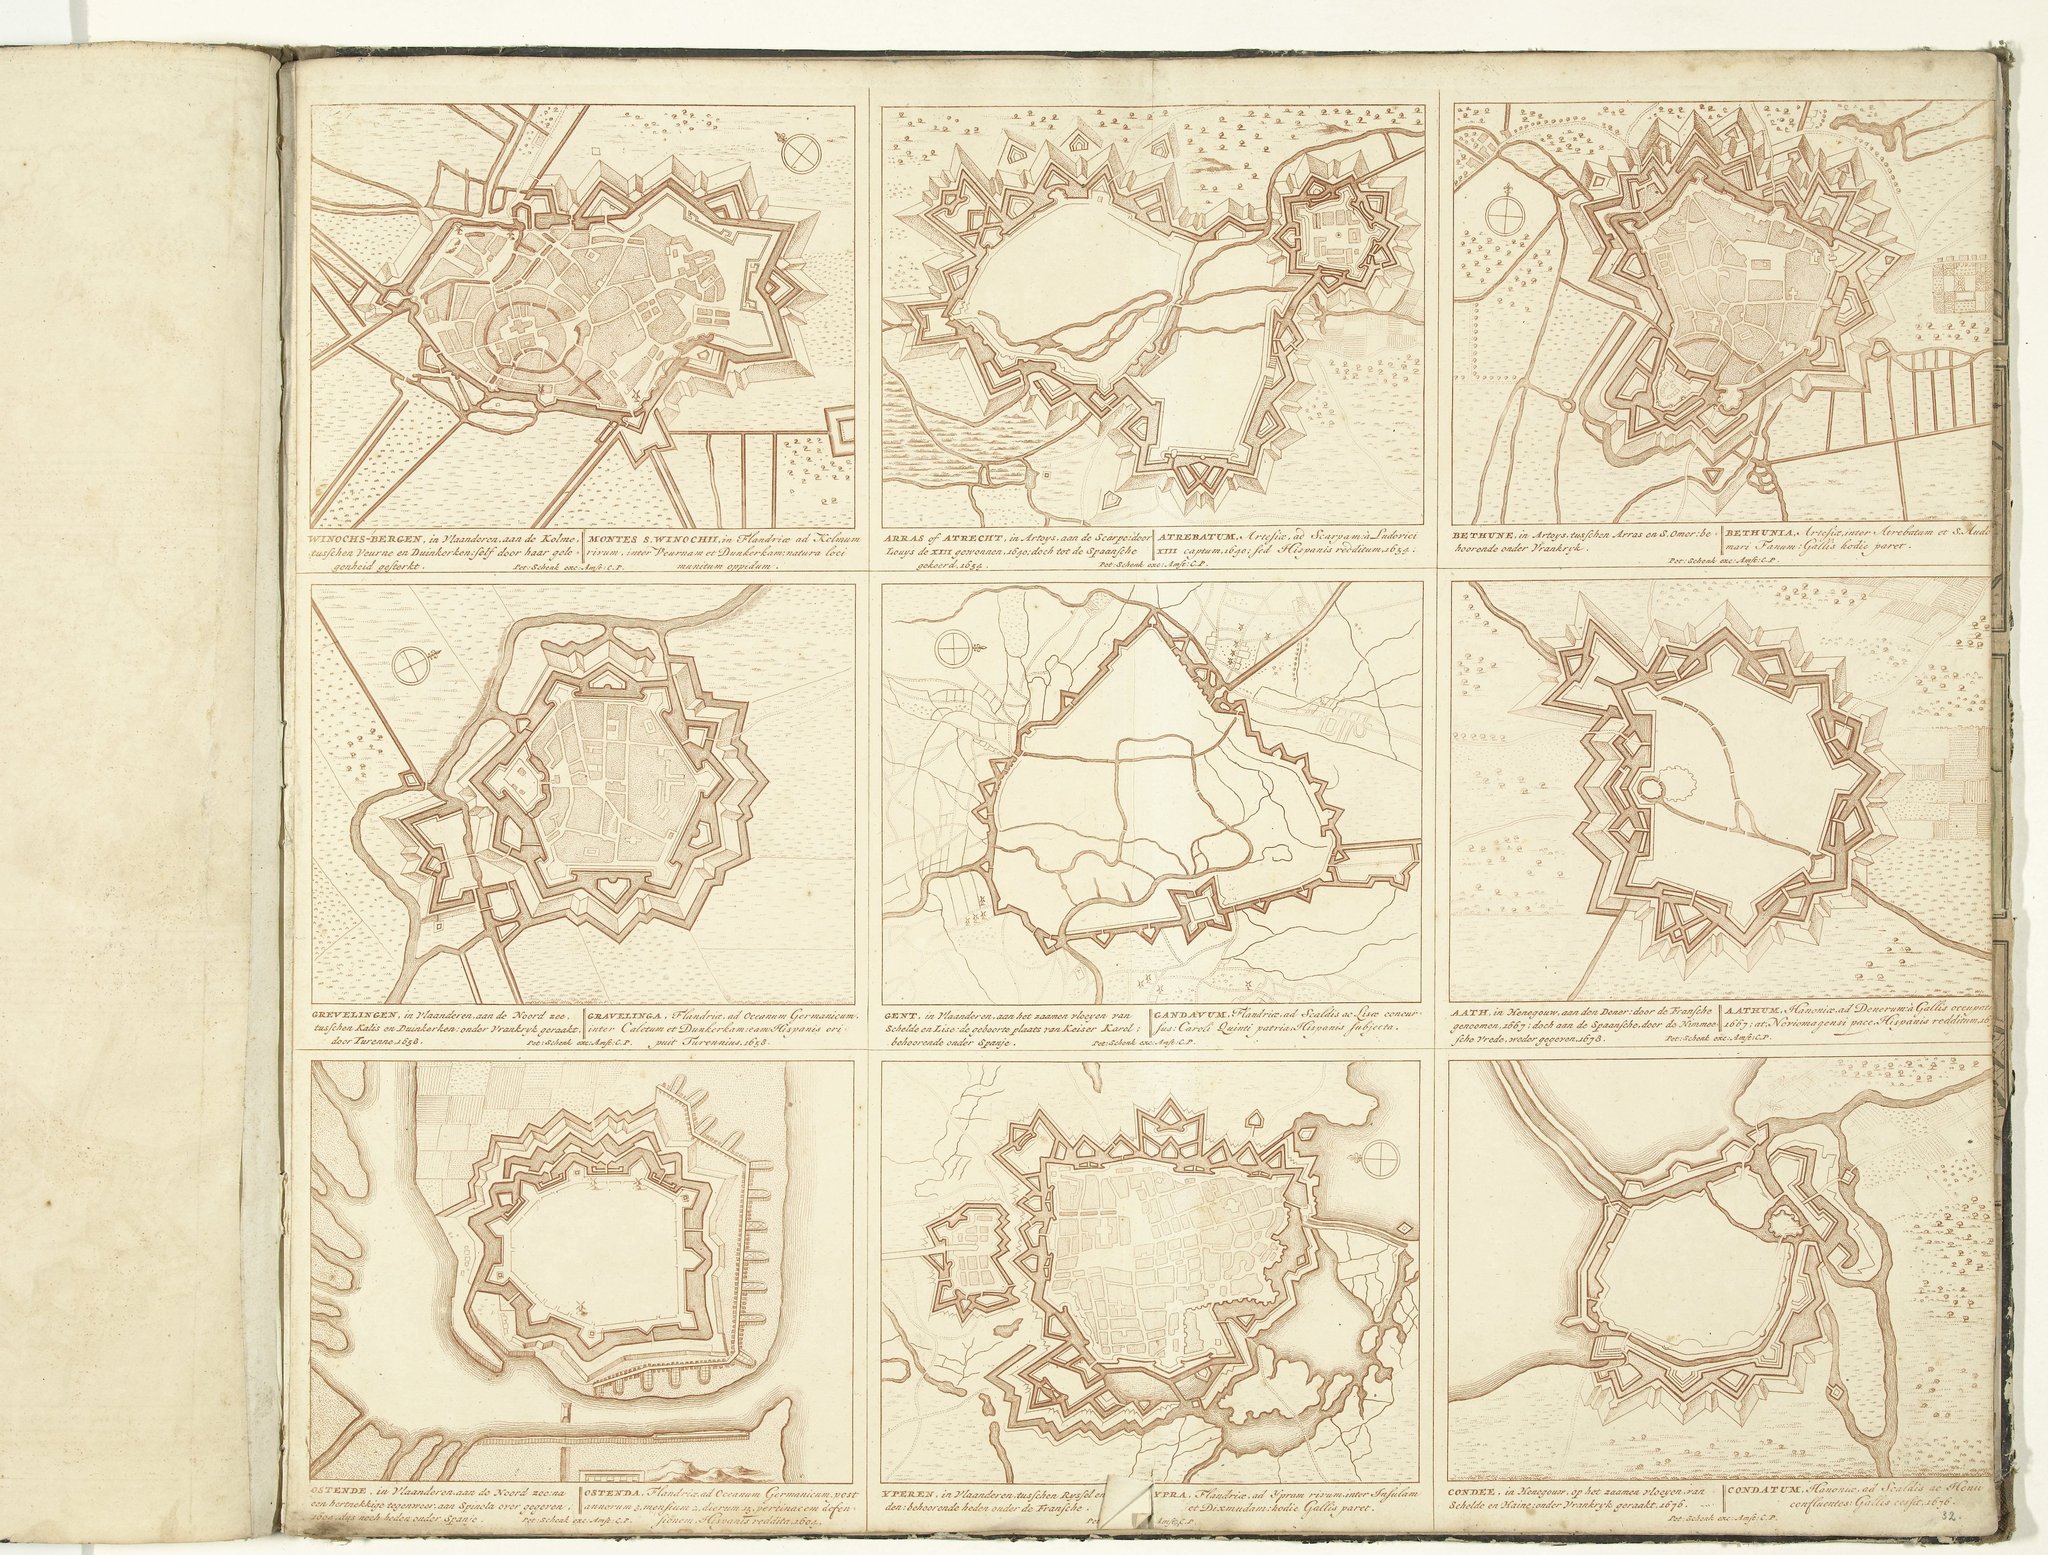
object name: print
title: Schouwburg van den oorlog (blad XXXII), ca. 1700-1710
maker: pieter schenk (i)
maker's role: print maker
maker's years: 1660-1711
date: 1700-1710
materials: paper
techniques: etching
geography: amsterdam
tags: fortress, maps of cities, ghent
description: Blad met negen plattegronden van de versterkingen van steden in de Spaanse Nederlanden. Blad XXXII in: Schouwburg van den oorlog (editie van 1709), het prentwerk met de gebundelde reeks van 18 platen over de Spaanse Successieoorlog.